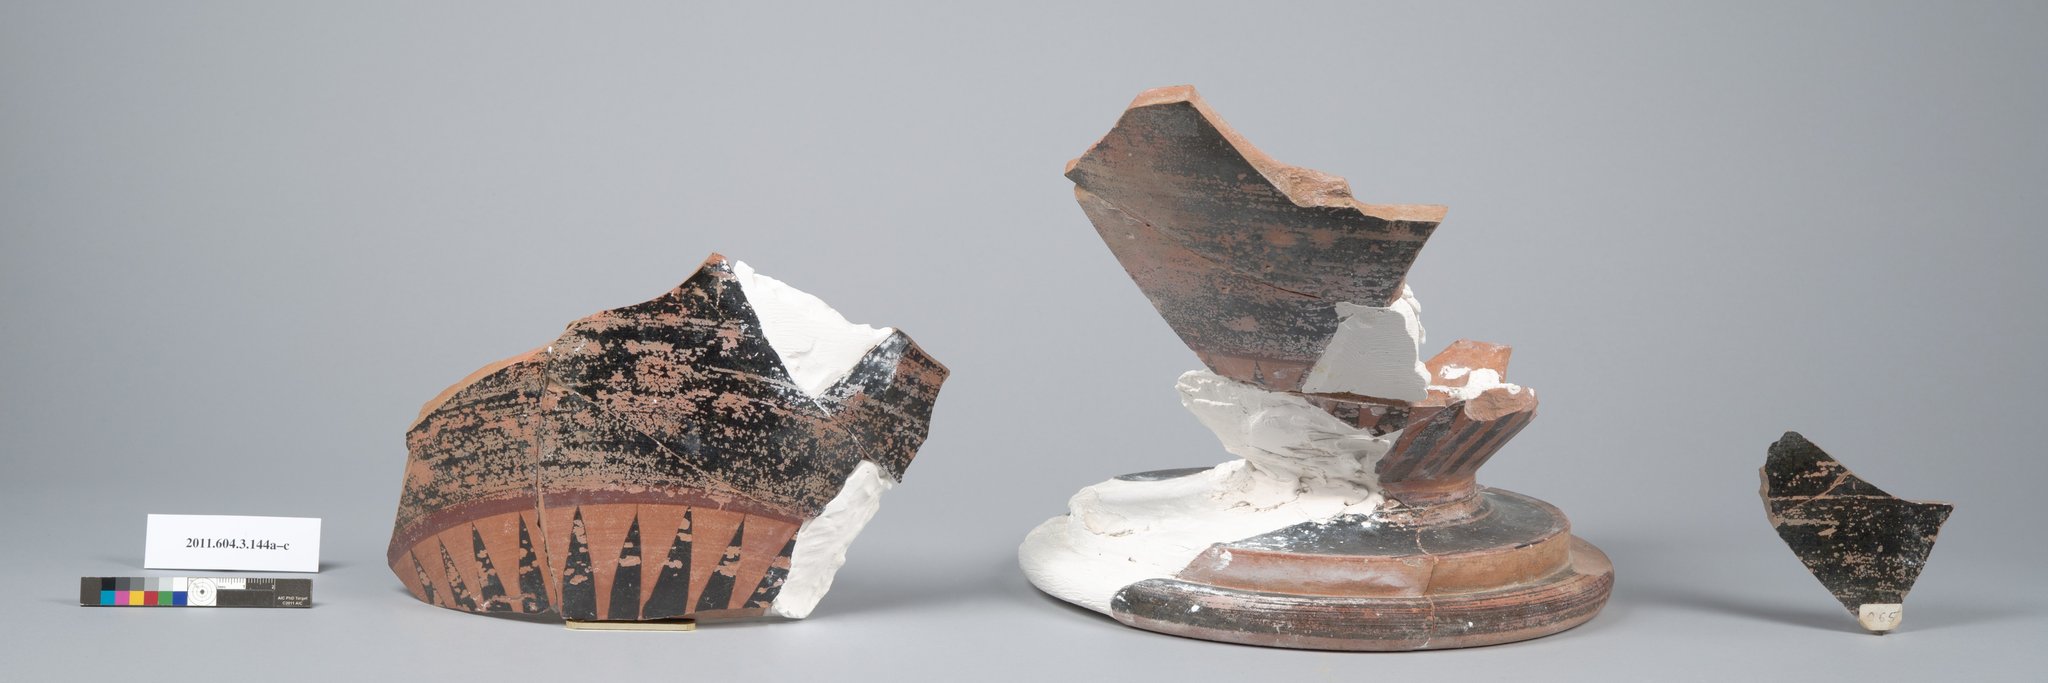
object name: amphora fragment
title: Terracotta fragments of an amphora (jar)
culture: greek, attic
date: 534-468 BCE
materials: terracotta